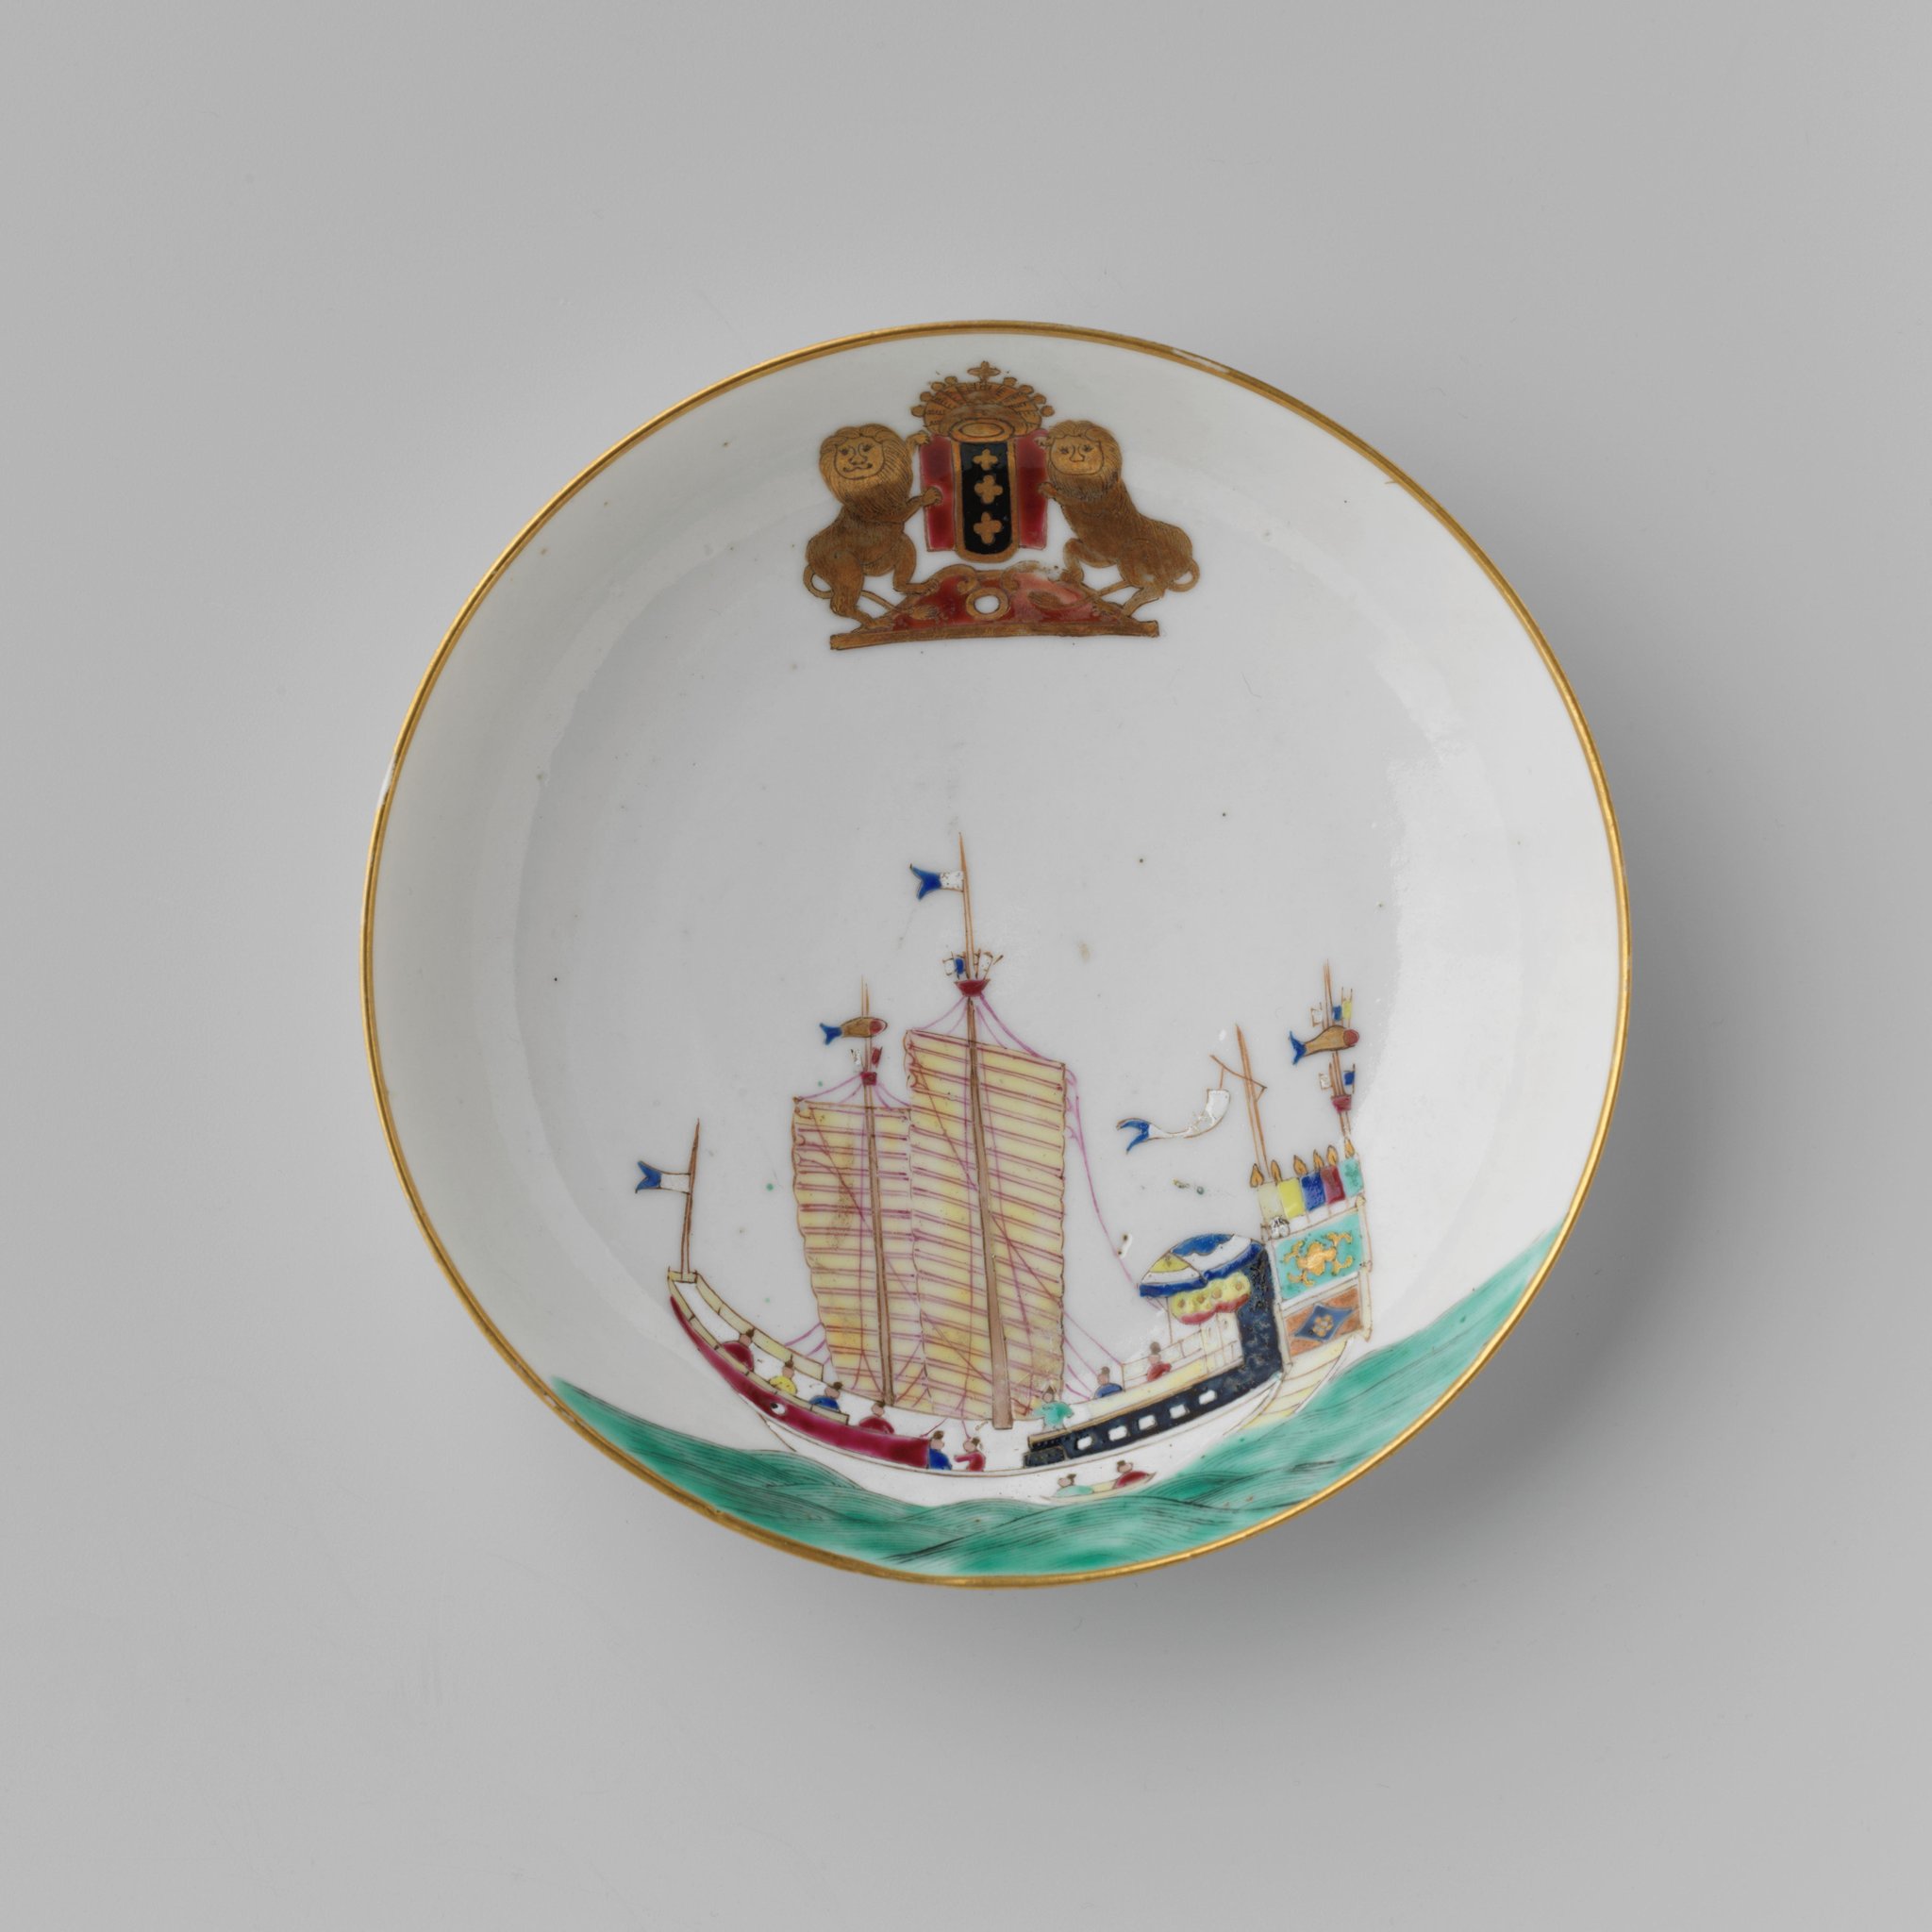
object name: platter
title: Saucer with a Chinese junk and the arms of Amsterdam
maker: Anonymous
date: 1800-1899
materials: glaze, gold, paint, porcelain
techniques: firing, gilding, turning, vitrification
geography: china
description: Kop en schotel van porselein. de kop is versierd met aan de ene zijde het wapen van Amsterdam, gehouden door twee leeuwen, en aan de andere zijde een Chineesche jonk. Op de schotel staat dezelfde versiering. 'Chine de Commande'.